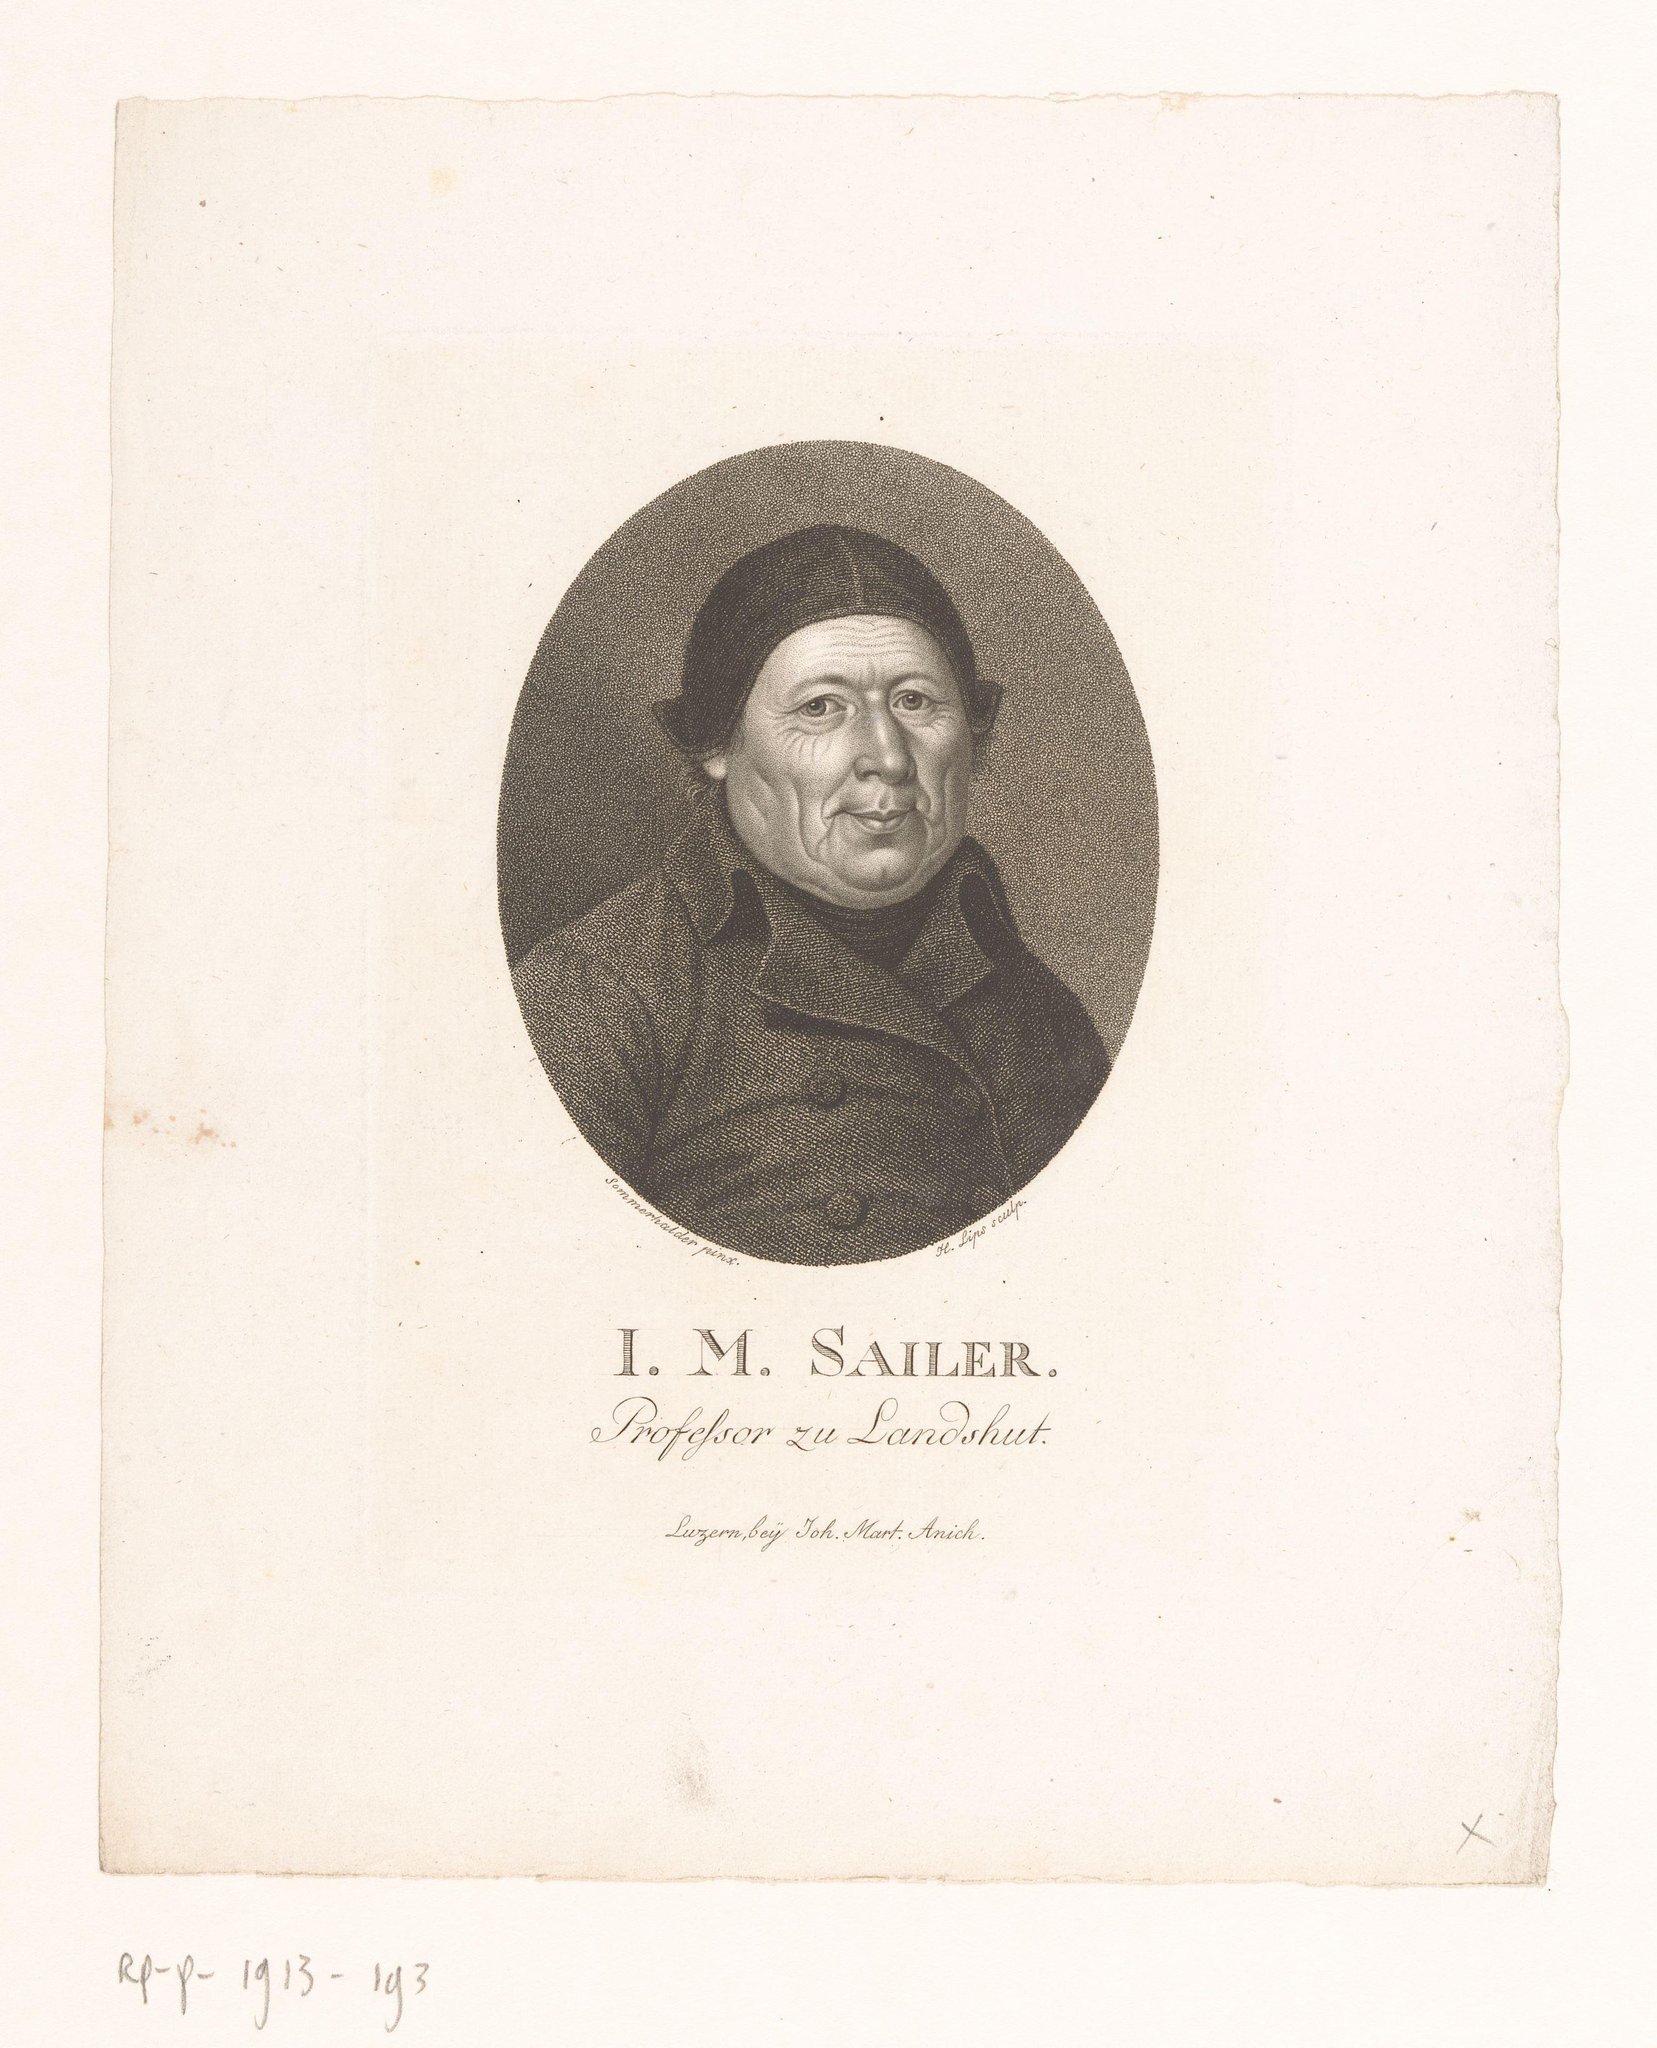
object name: print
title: Portret van Johann Michael Sailer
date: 1768-1817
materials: paper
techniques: engraving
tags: historical persons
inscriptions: collector's mark: Lugt 2228